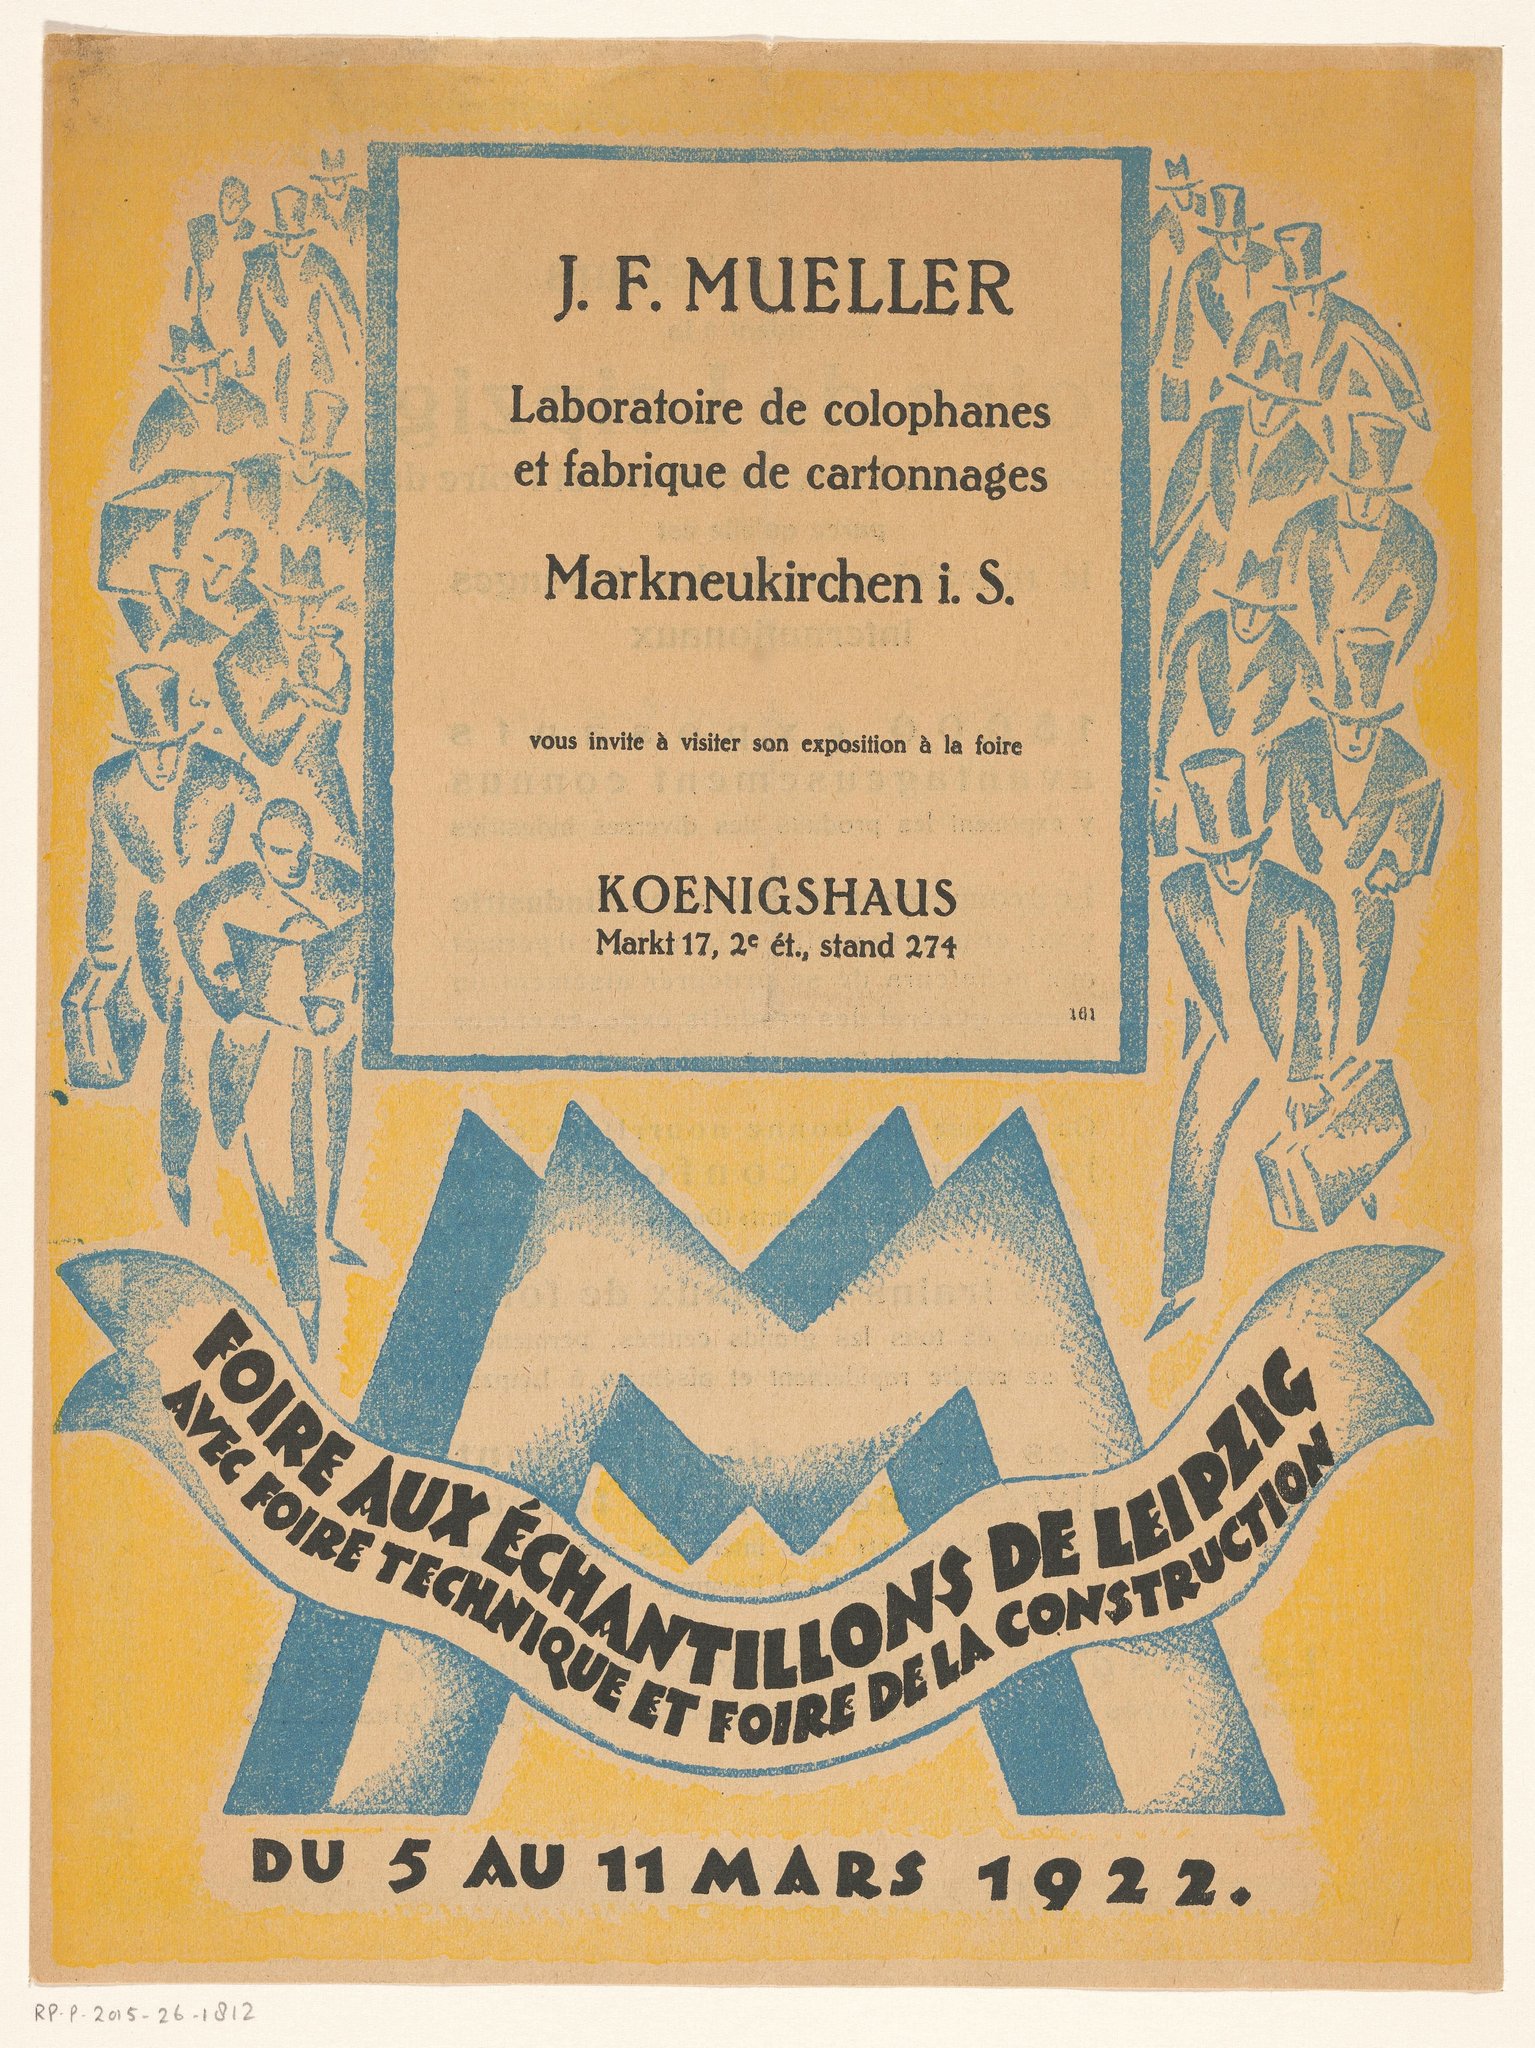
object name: reclamebiljet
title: Reclamebiljet voor J.F. Mueller, fabrikant te Markneukirchen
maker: Anonymous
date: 1903-1922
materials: paper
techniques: lithograph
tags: trade exhibition, industries fair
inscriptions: collector's mark: Lugt 4780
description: Dit reclamebiljet is vervaardigd voor een beurs in Leipzig, gehouden van 5 tot 11 maart 1922.